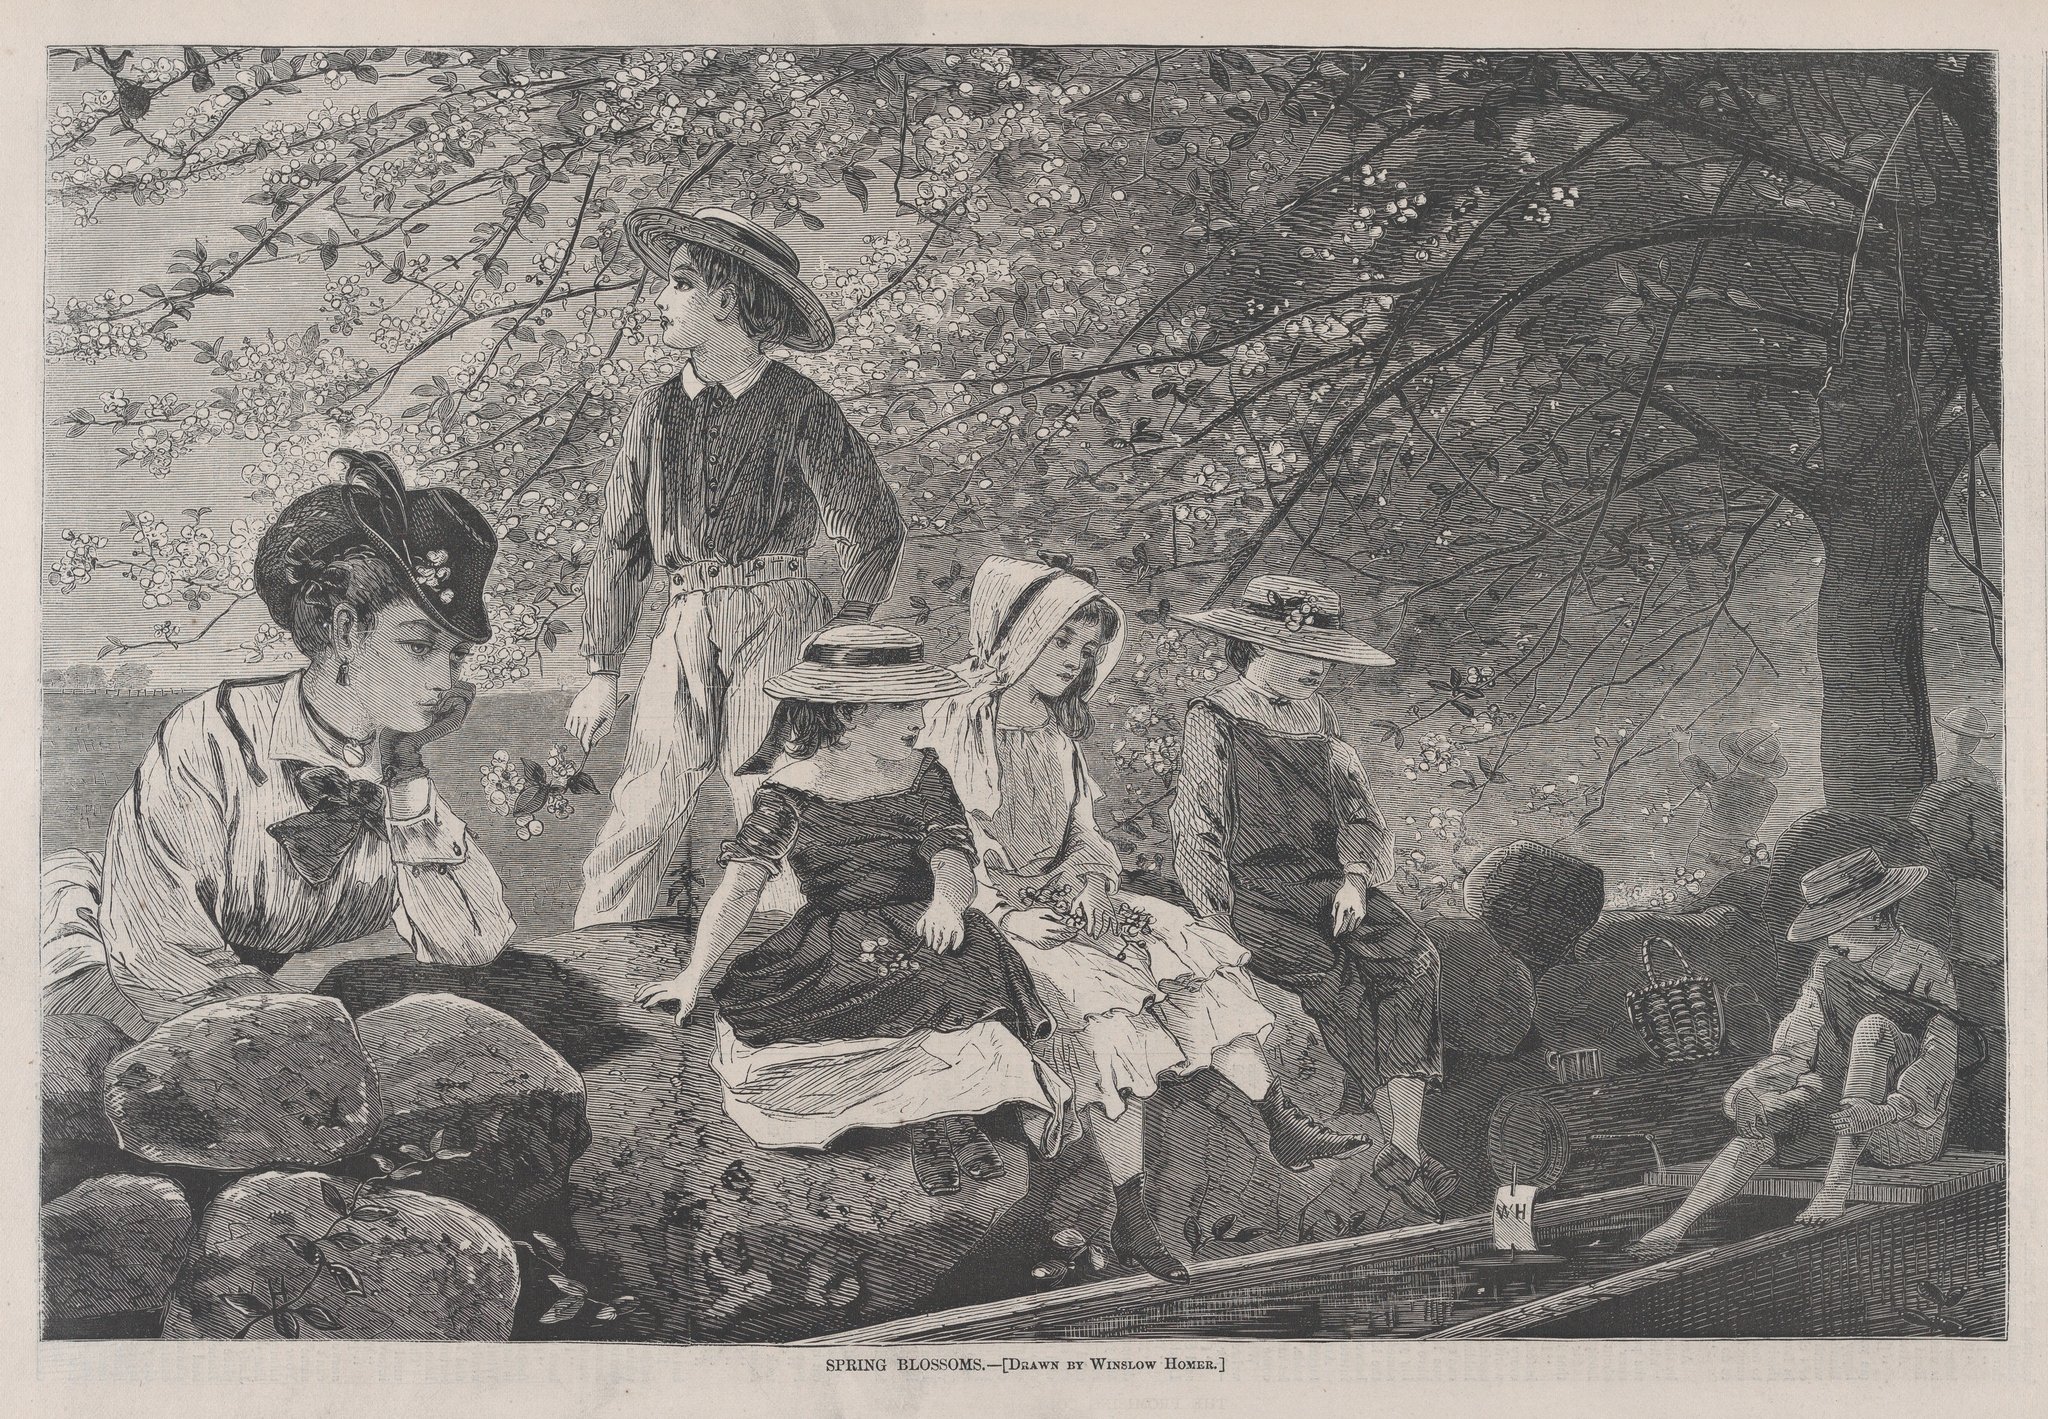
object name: print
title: Spring Blossoms (from "Harper's Weekly," Vol. XIV)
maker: winslow homer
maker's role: artist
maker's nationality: american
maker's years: 1836-1910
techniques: engraving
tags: girls,women,flowers,trees,spring